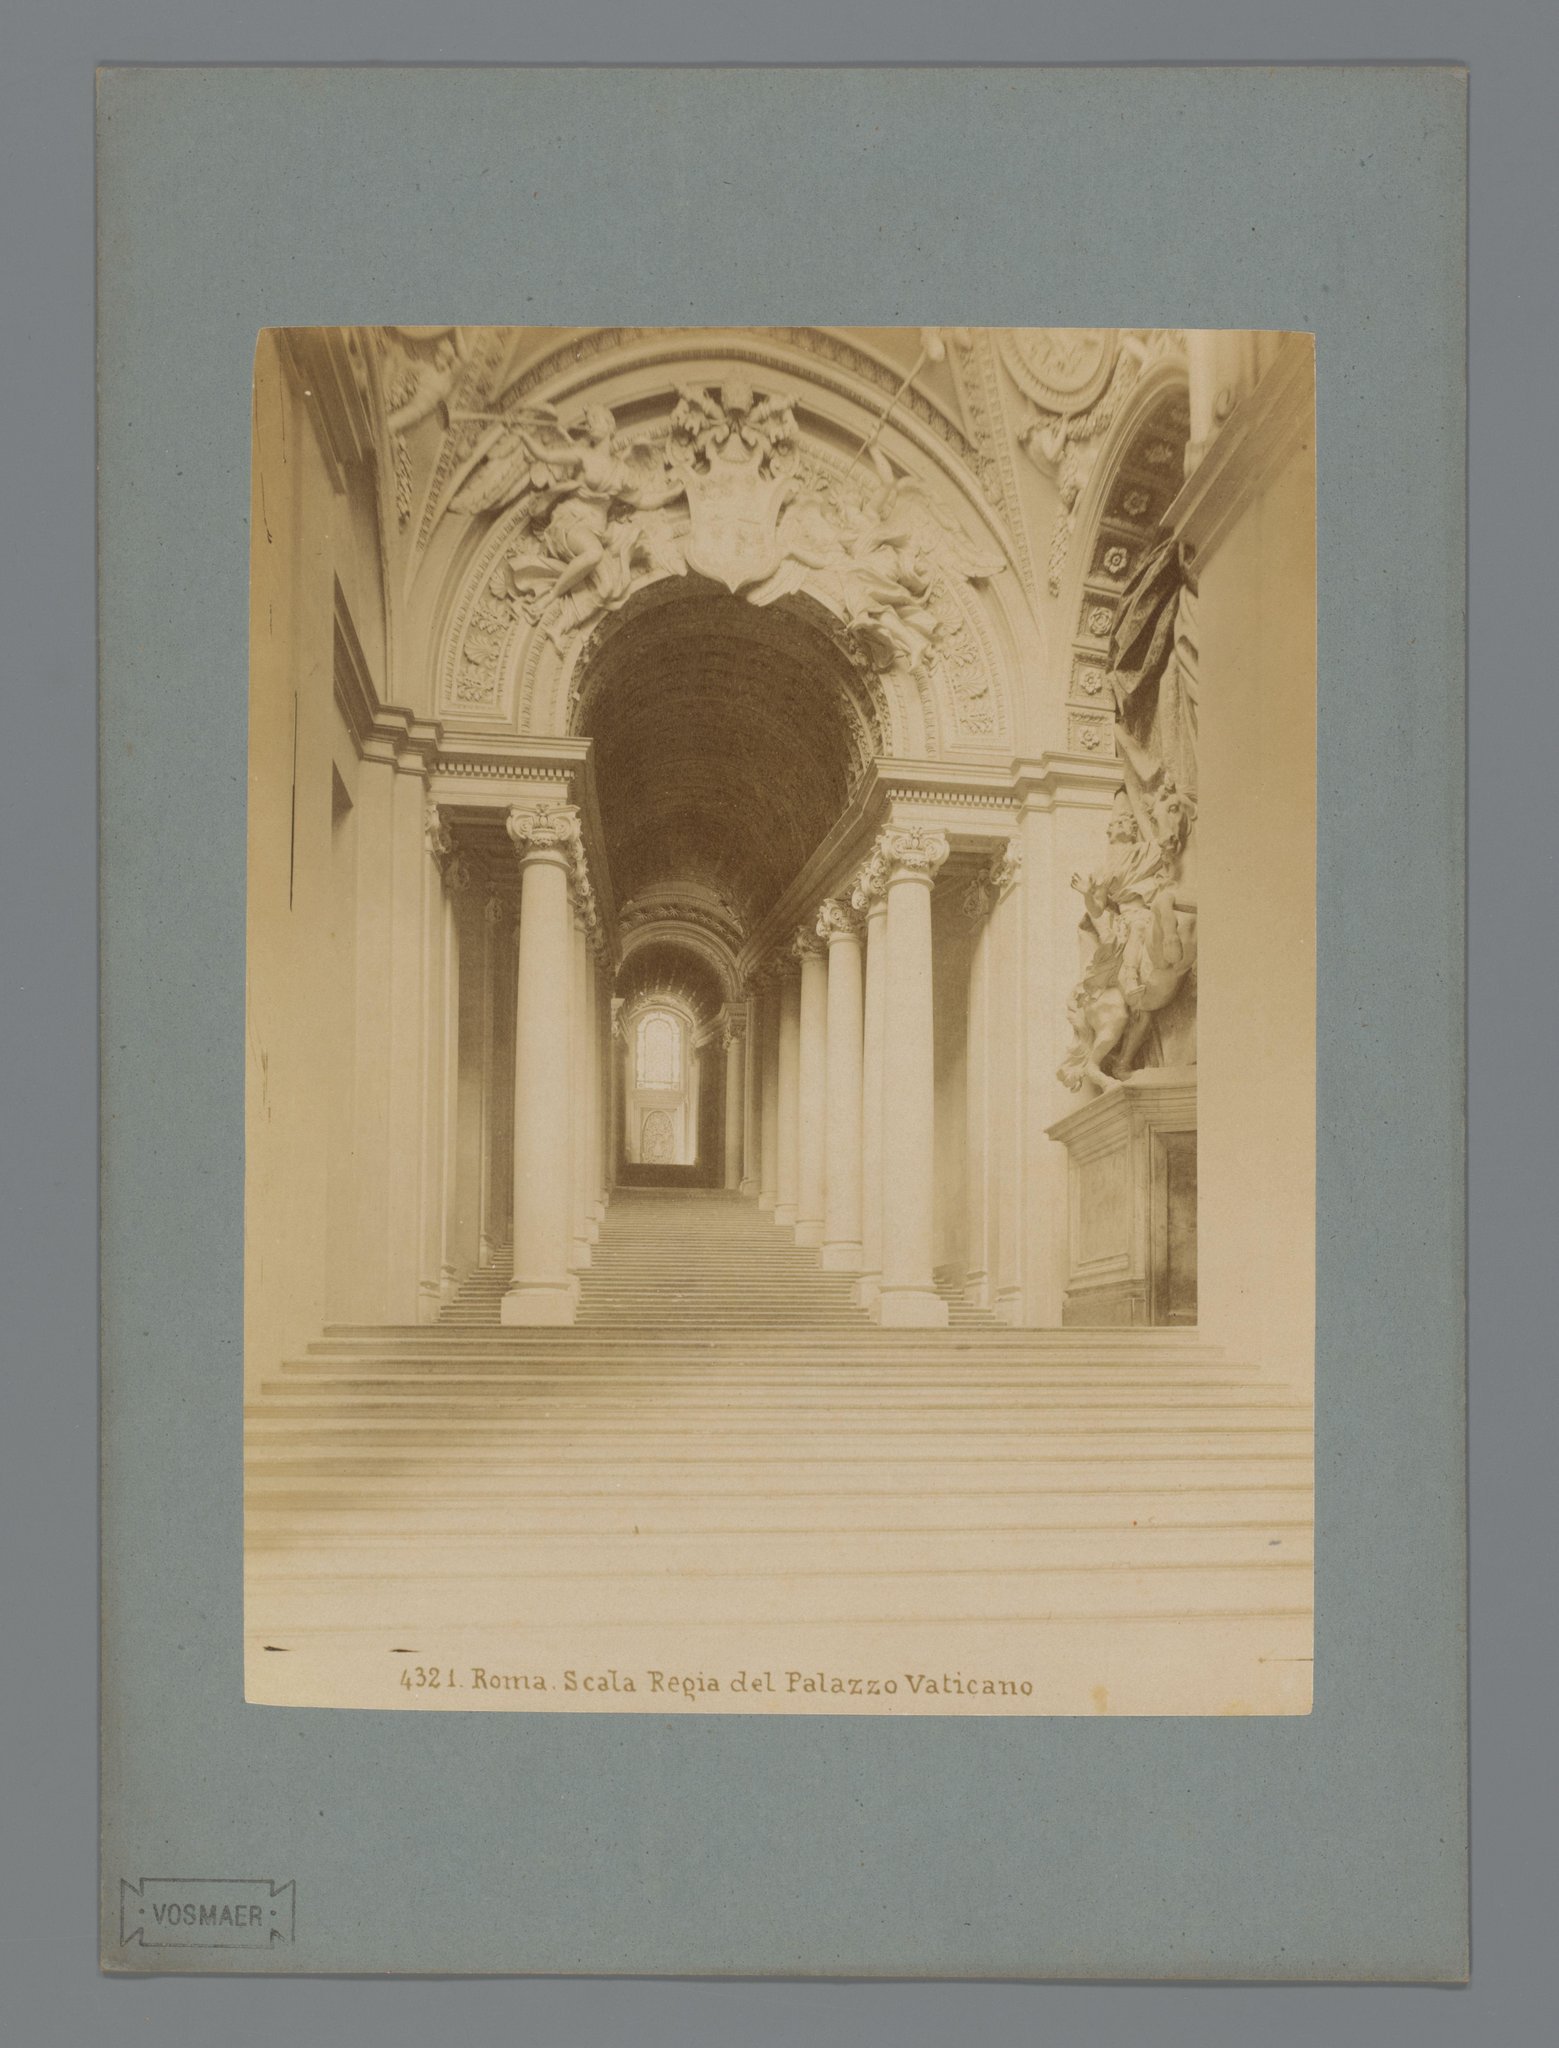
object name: photograph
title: Roma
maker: Anonymous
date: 1851-1890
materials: cardboard, paper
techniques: albumen print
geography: vatican city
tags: palace, gallery (spacious corridor)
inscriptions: collector's mark: ‘VOSMAER’, number: ‘4321.’